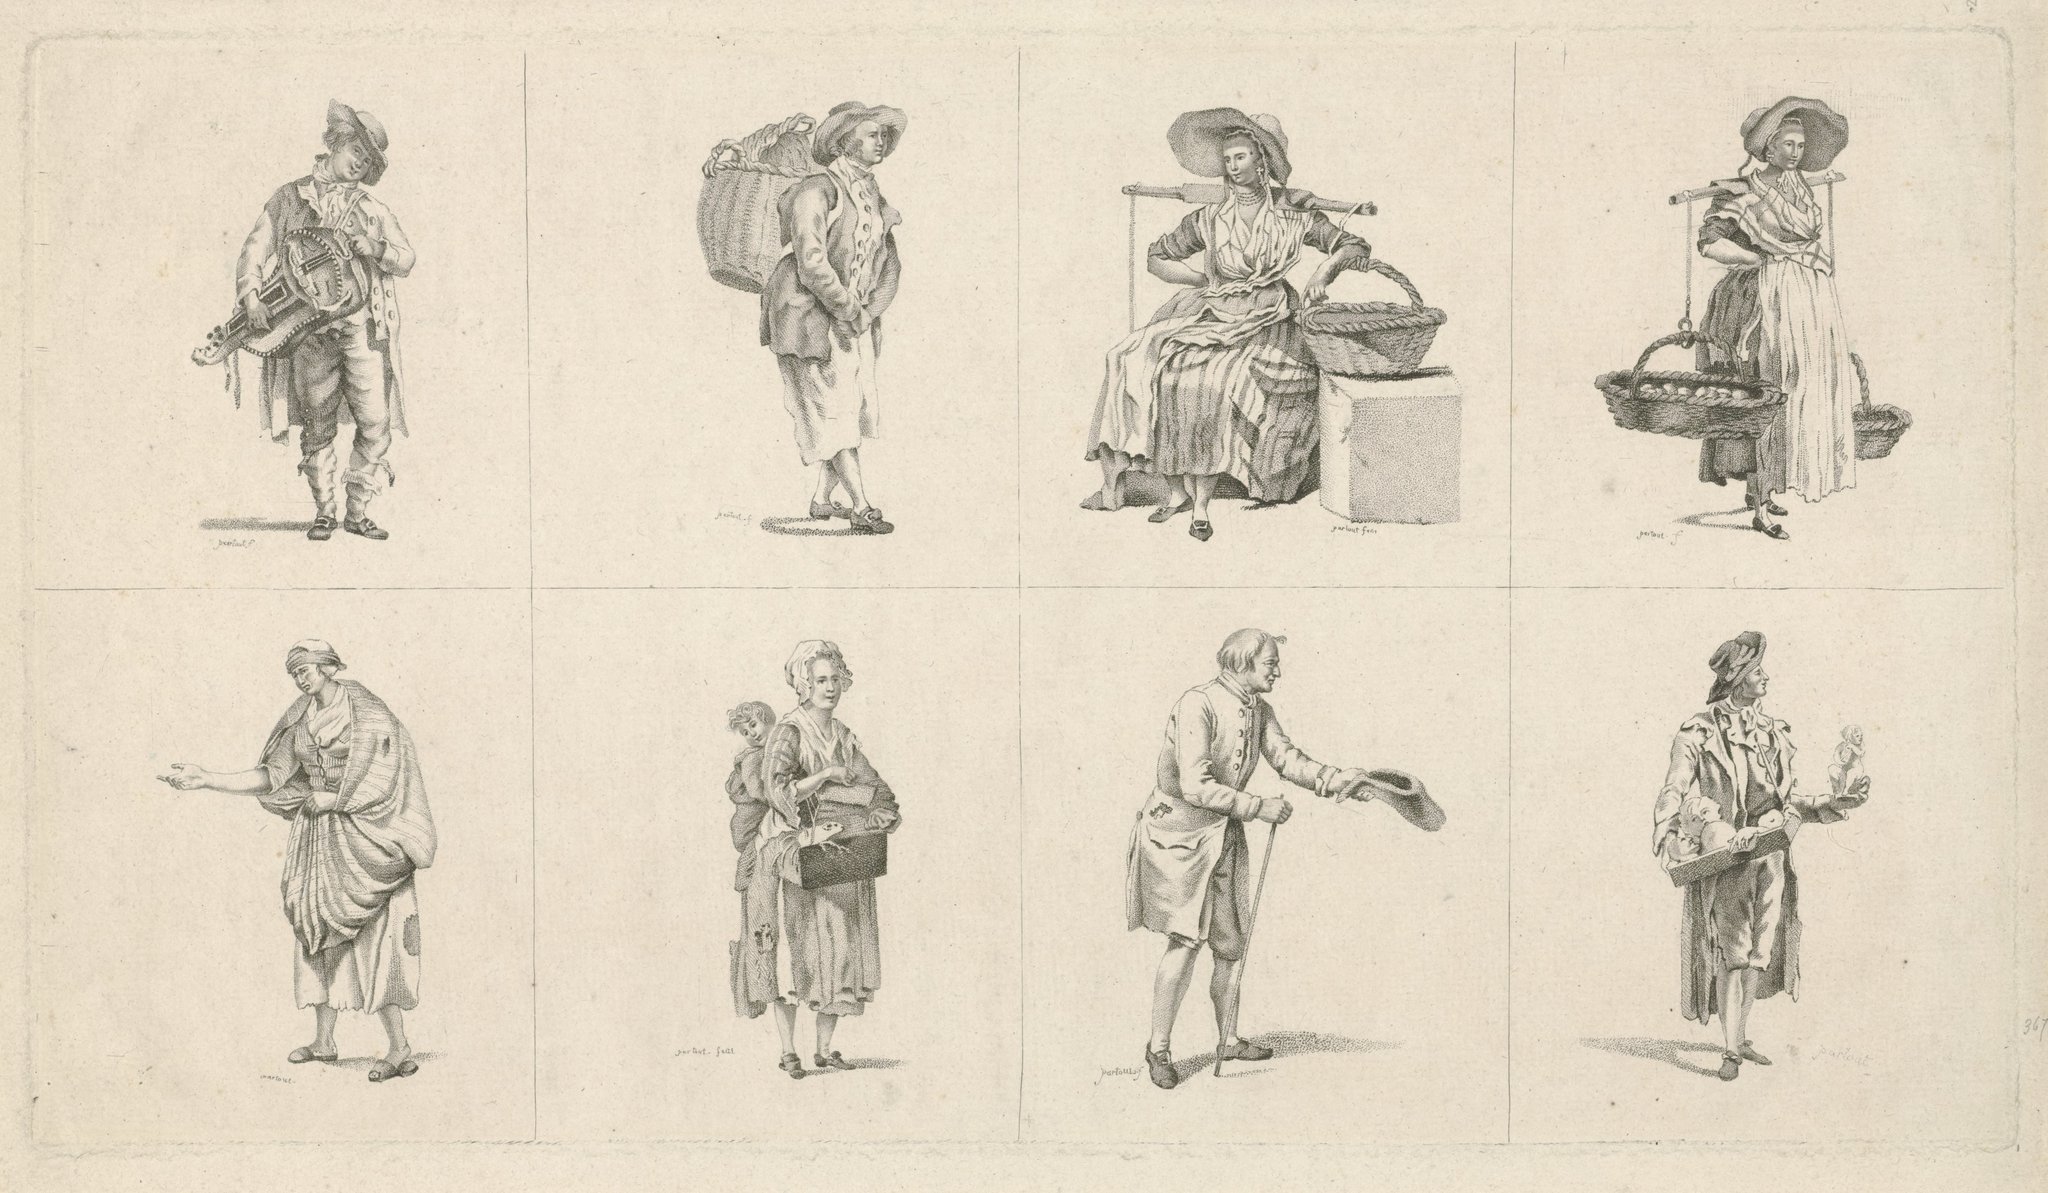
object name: print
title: Mannen en vrouwen met verschillende beroepen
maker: h. partout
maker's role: print maker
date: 1769-1789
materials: paper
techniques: stippled etching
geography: zeeland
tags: labour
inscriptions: collector's mark: Lugt 2228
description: Acht voorstellingen van mannen en vrouwen in verschillende beroepen, waaronder een lierspeler, een bedelares en een koopman.